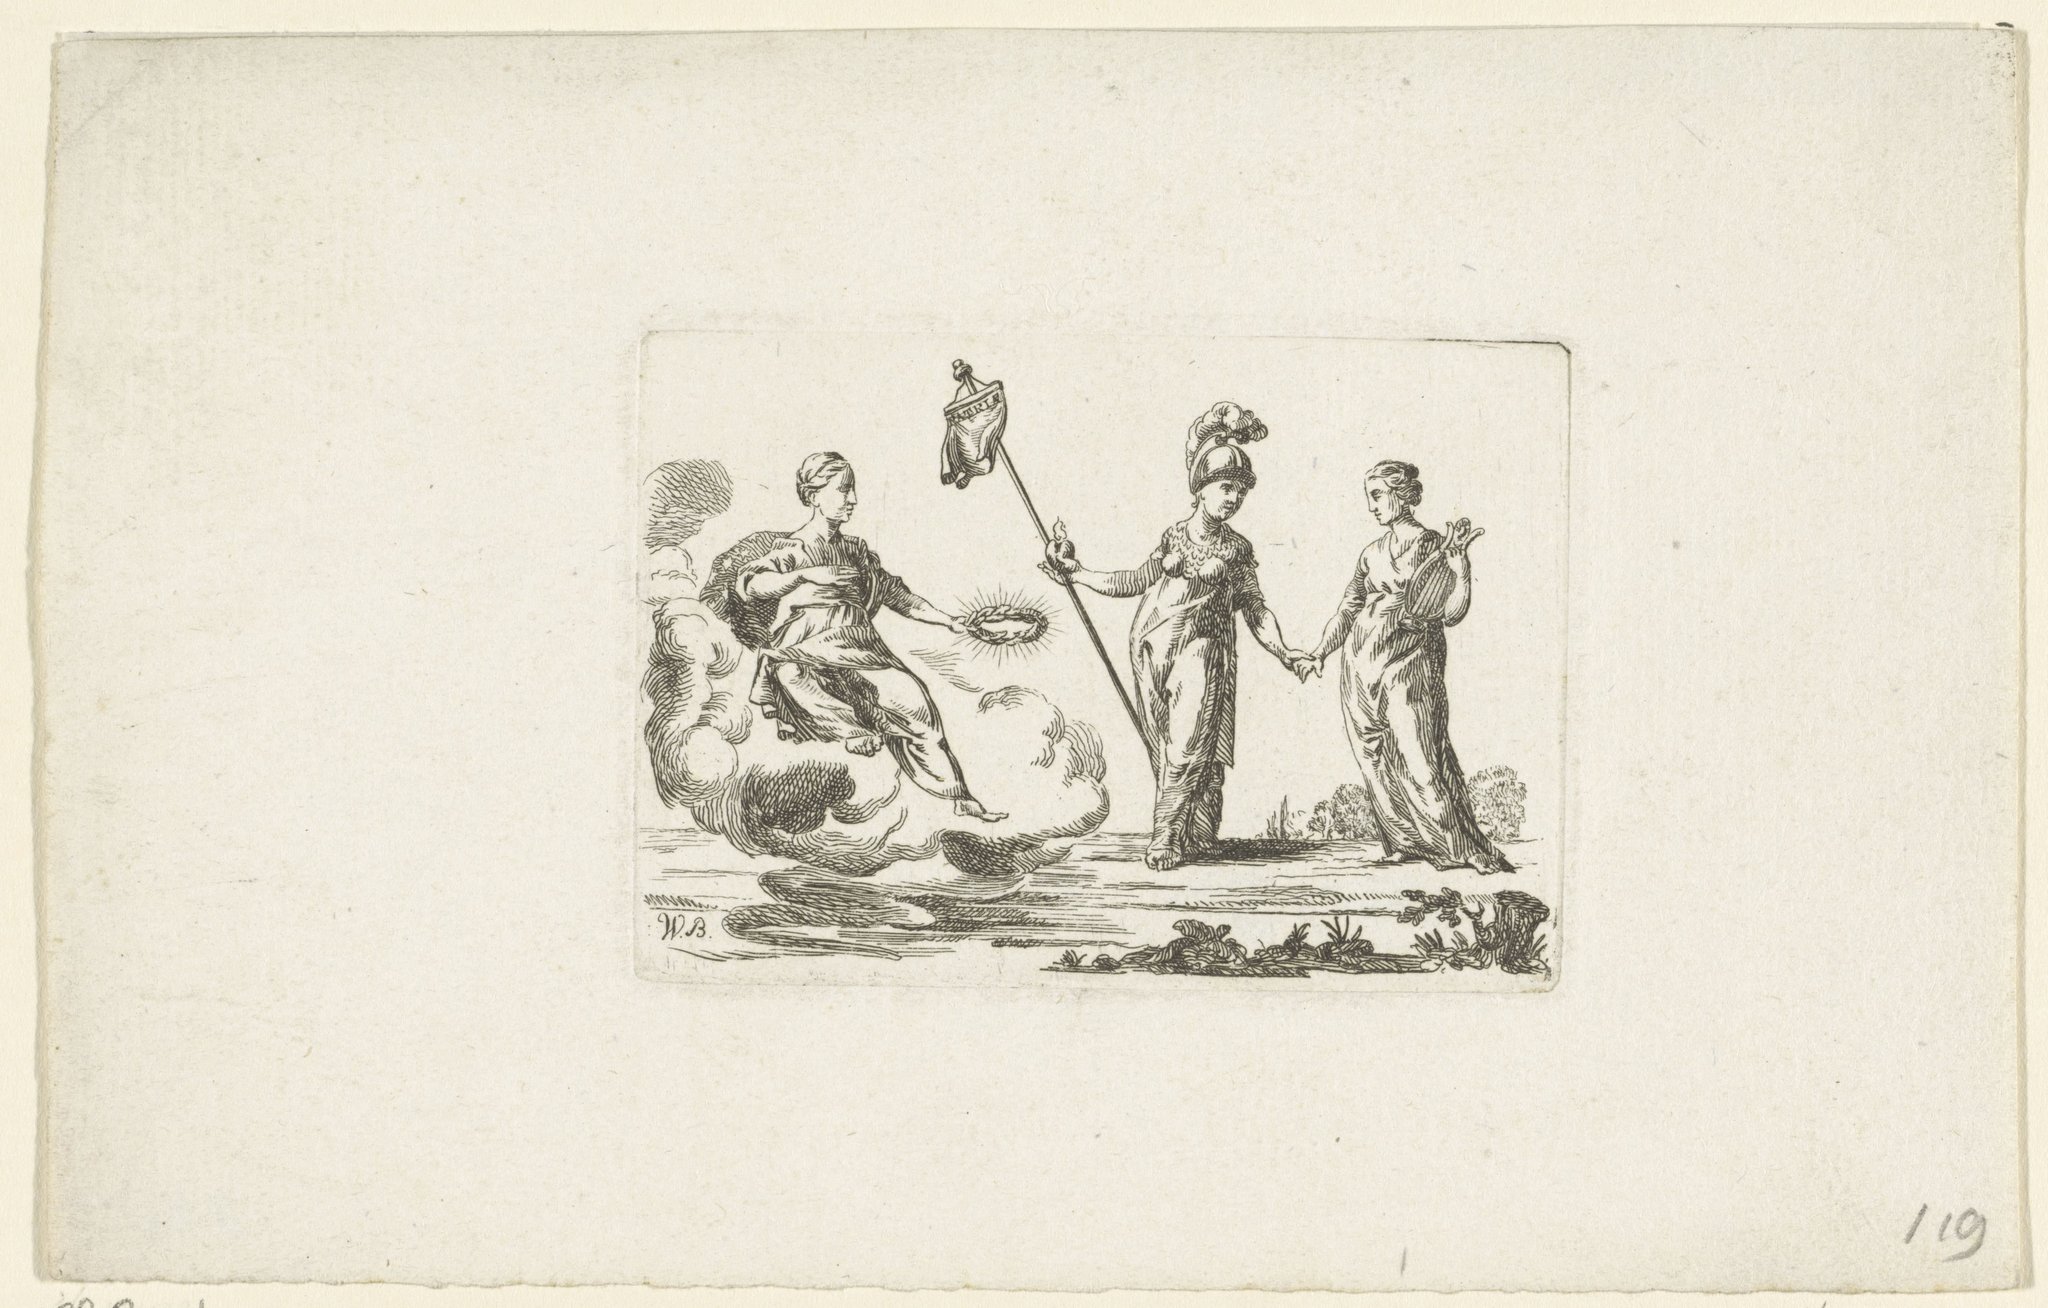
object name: print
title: Minerva leidt een vrouw naar een muze om gelauwerd te worden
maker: willem bilderdijk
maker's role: draughtsman, print maker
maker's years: 1756-1831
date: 1776-1831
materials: paper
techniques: etching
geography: netherlands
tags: (story of) minerva (pallas, athena), single muses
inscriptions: collector's mark: Lugt 2760, collector's mark: Lugt 2228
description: Op een wolk zit een muze met een lauwerkrans in de hand. Minerva houdt de banier van het vaderland en brandend hart in de hand en leidt een vrouw met harp in de hand naar de muze.